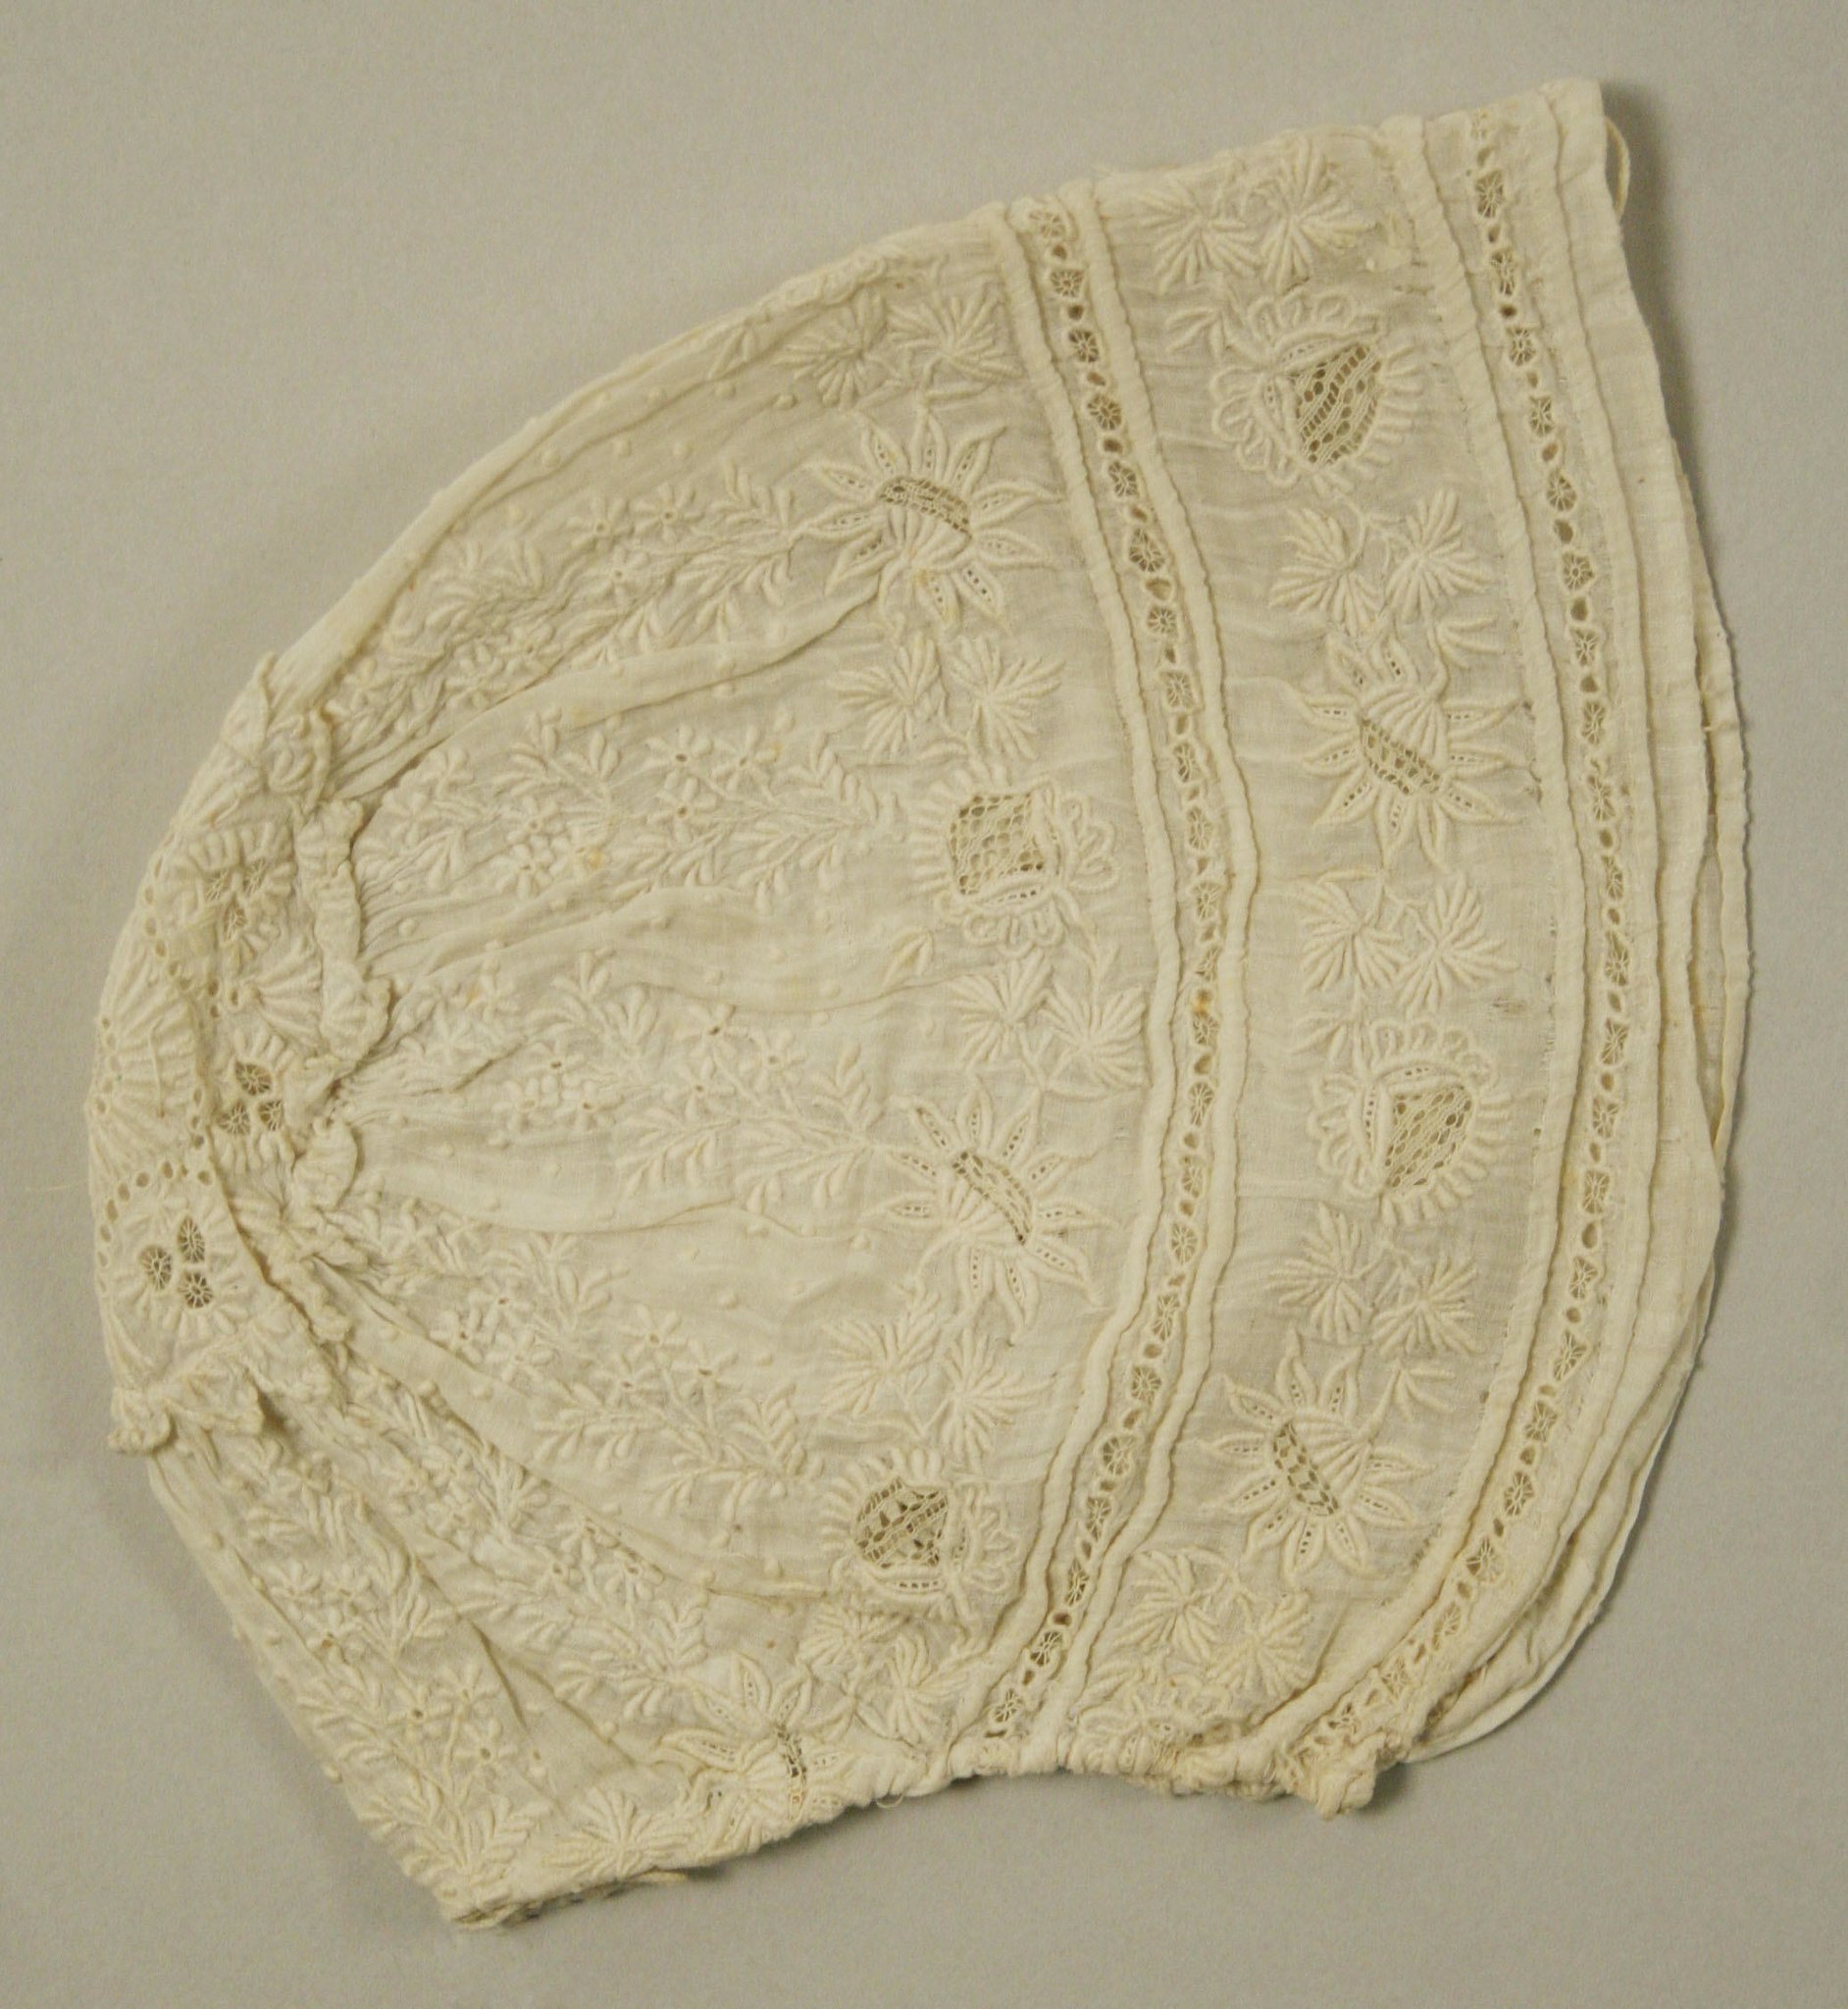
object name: cap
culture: british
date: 1801-1900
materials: linen